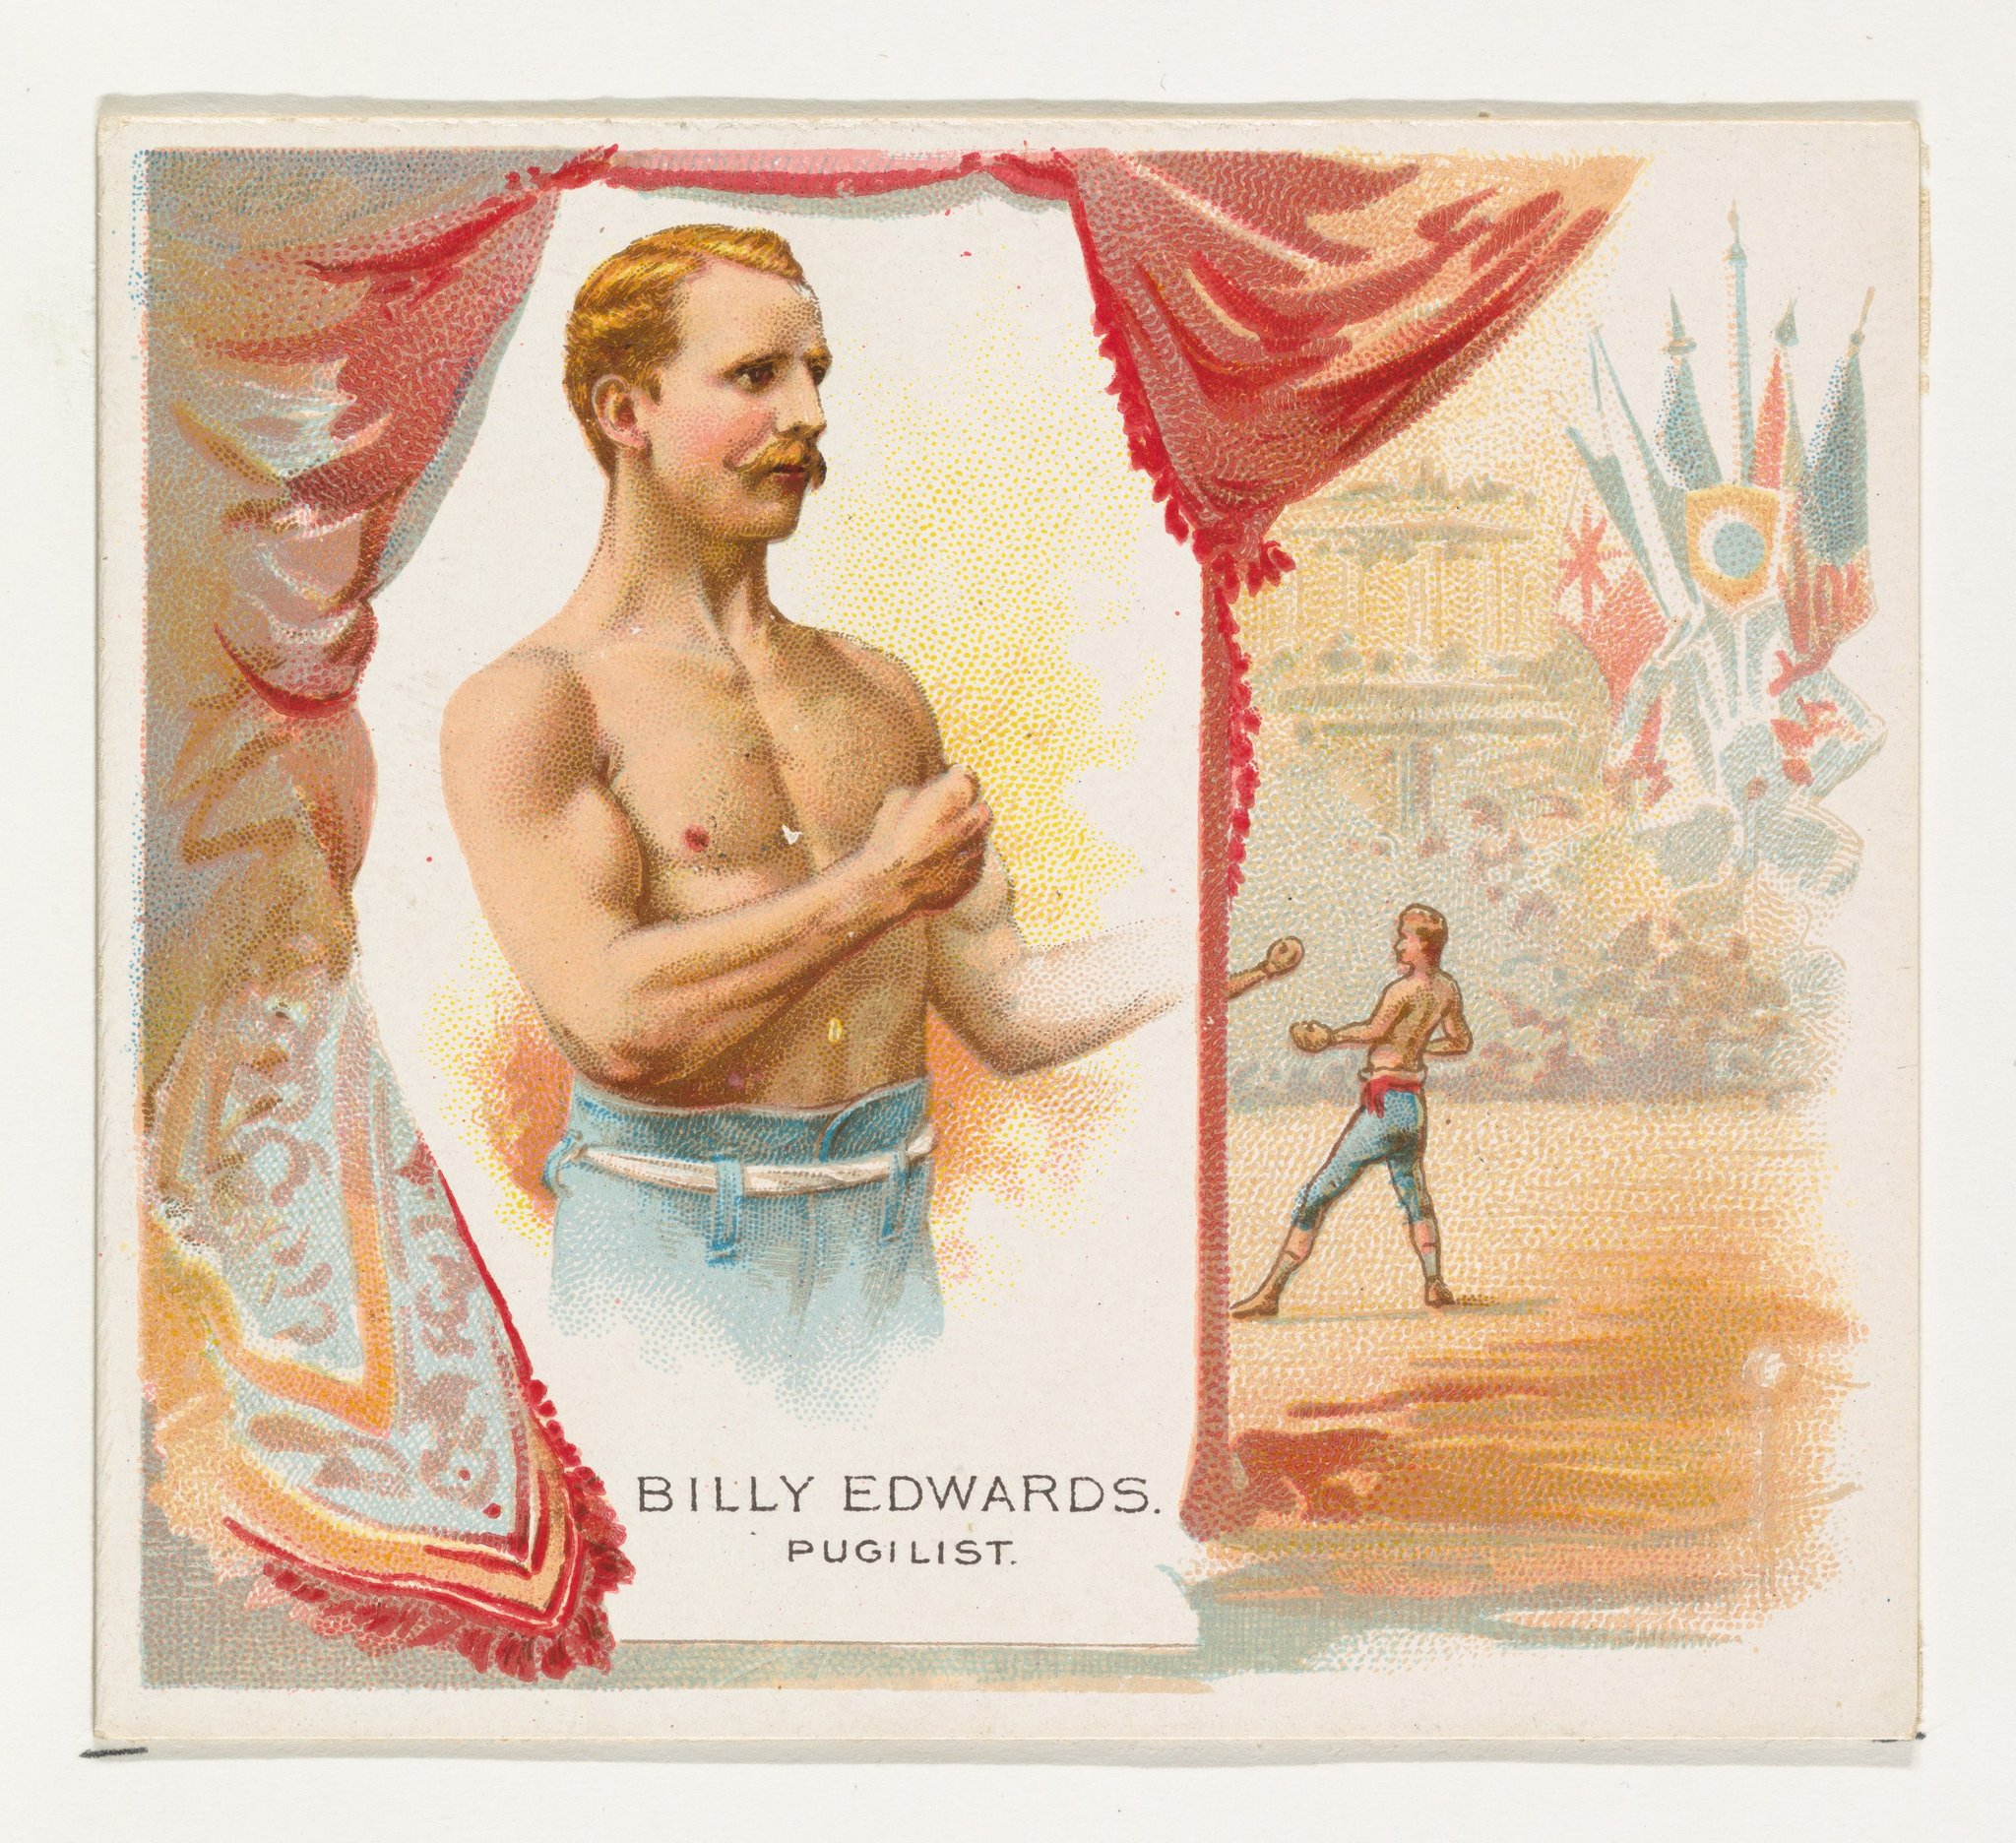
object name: print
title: Billy Edwards, Pugilist, from World's Champions, Second Series (N43) for Allen & Ginter Cigarettes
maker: allen & ginter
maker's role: publisher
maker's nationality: american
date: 1888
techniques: lithography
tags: men,profiles,athletes